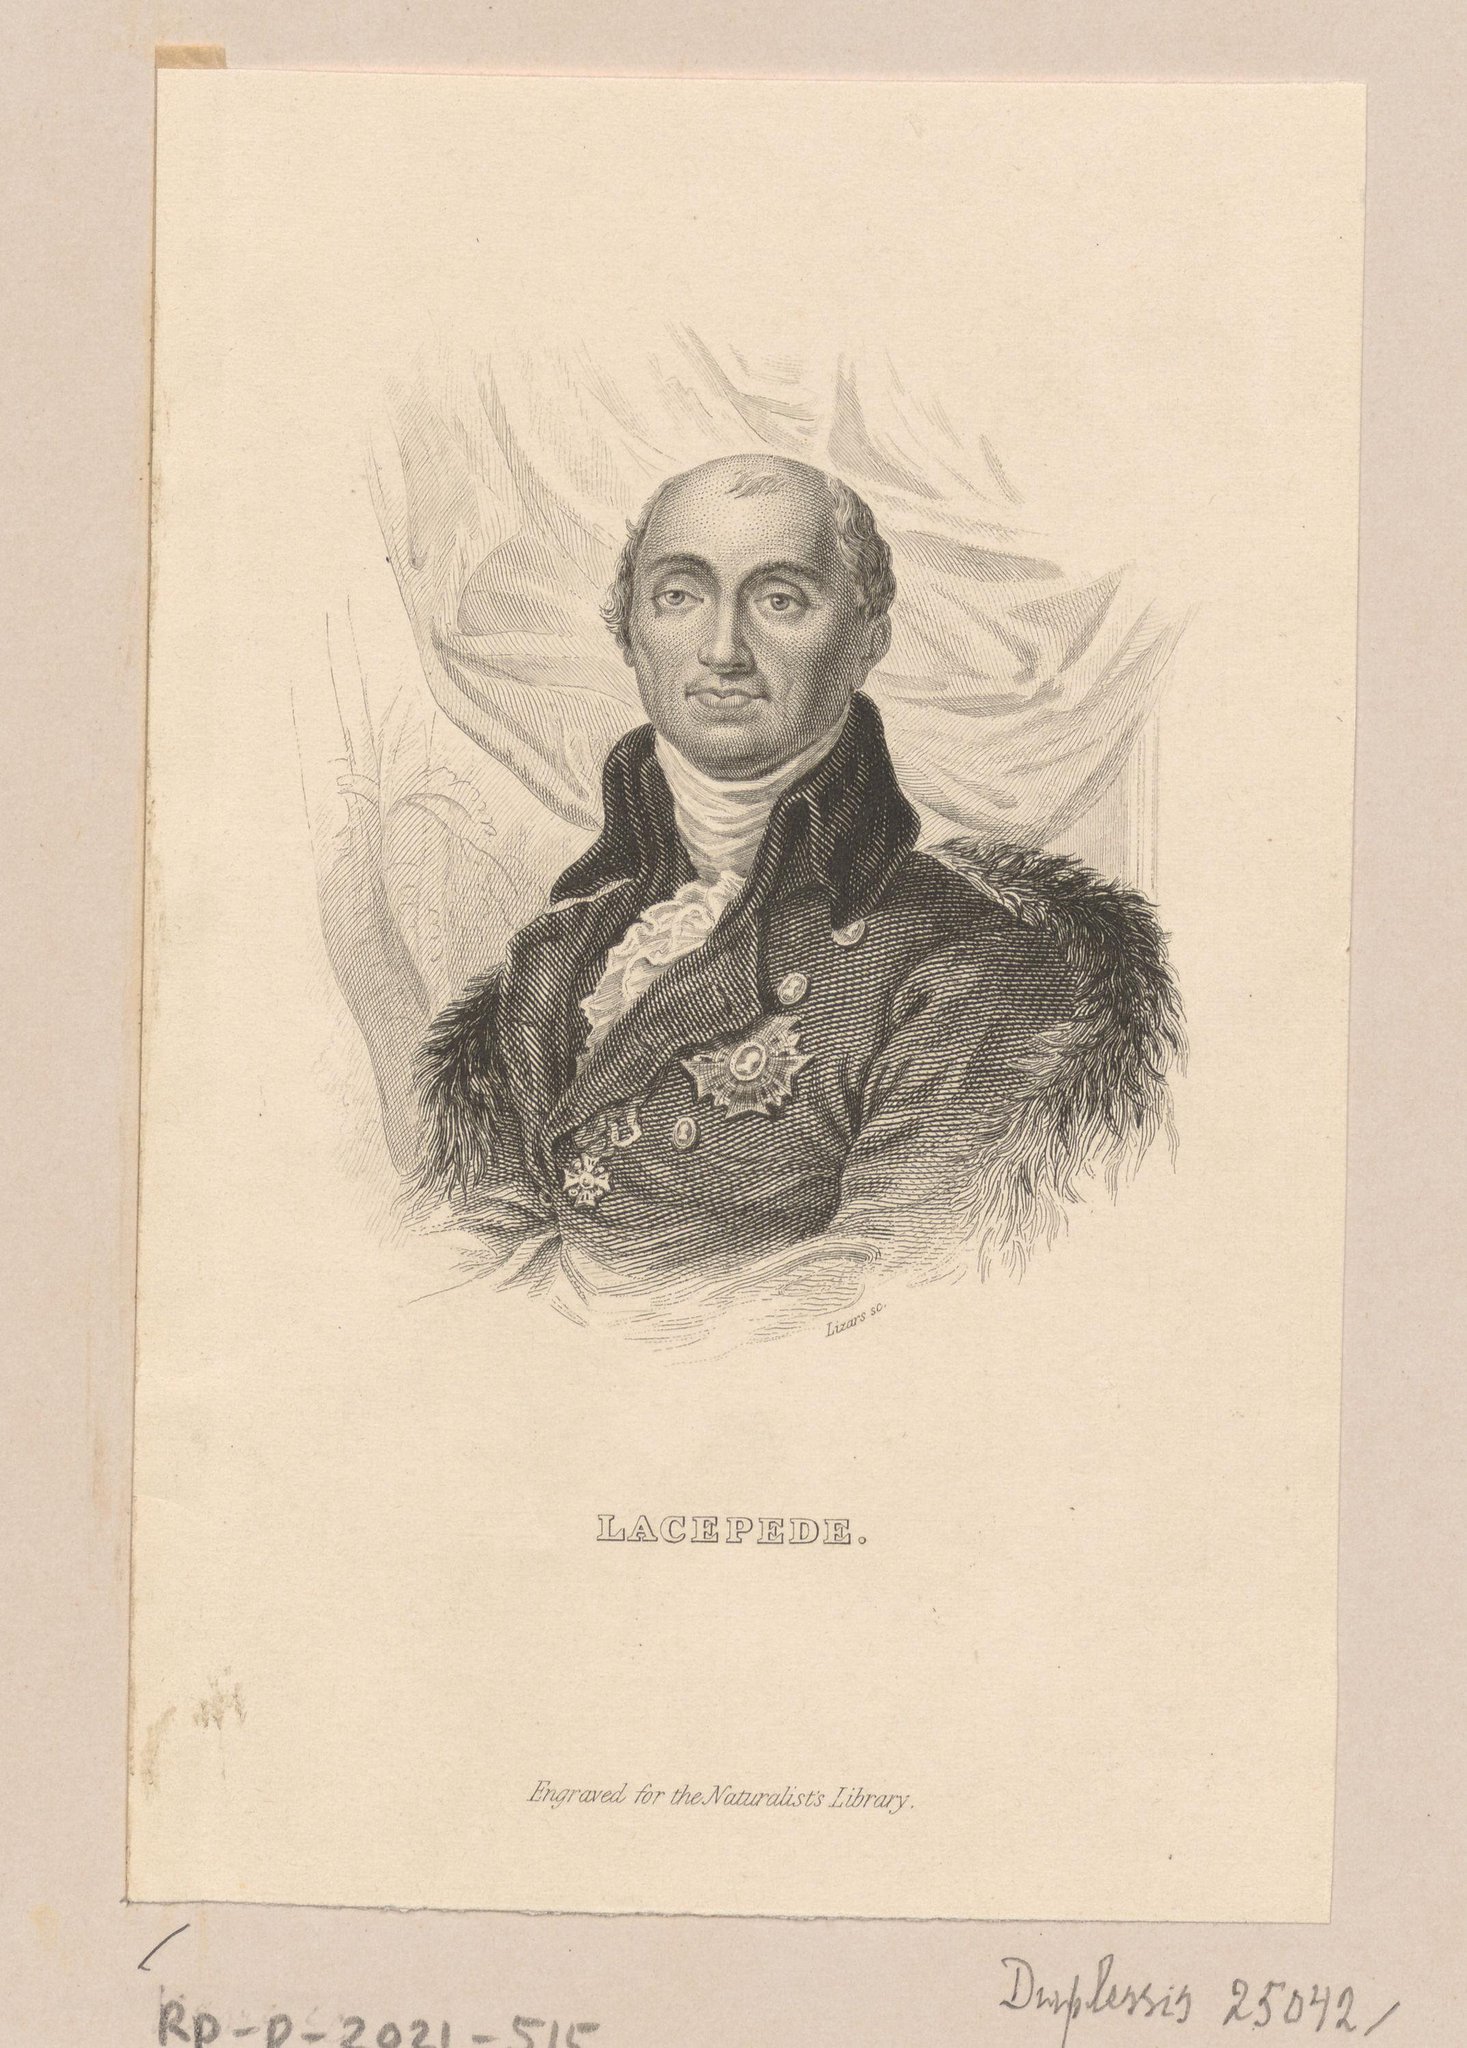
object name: book illustration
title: Portret van Bernard Germain de Lacépède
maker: william home lizars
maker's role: print maker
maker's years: 1788-1859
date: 1837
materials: paper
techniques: etching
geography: edinburgh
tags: politician, historical persons, politician, e.g. party leader, (military) uniforms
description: Prent waarschijnlijk uit: Jadine, William. The Naturalist's Library (...). Edinburgh: William Home Lizars, 1837, dl. 6.